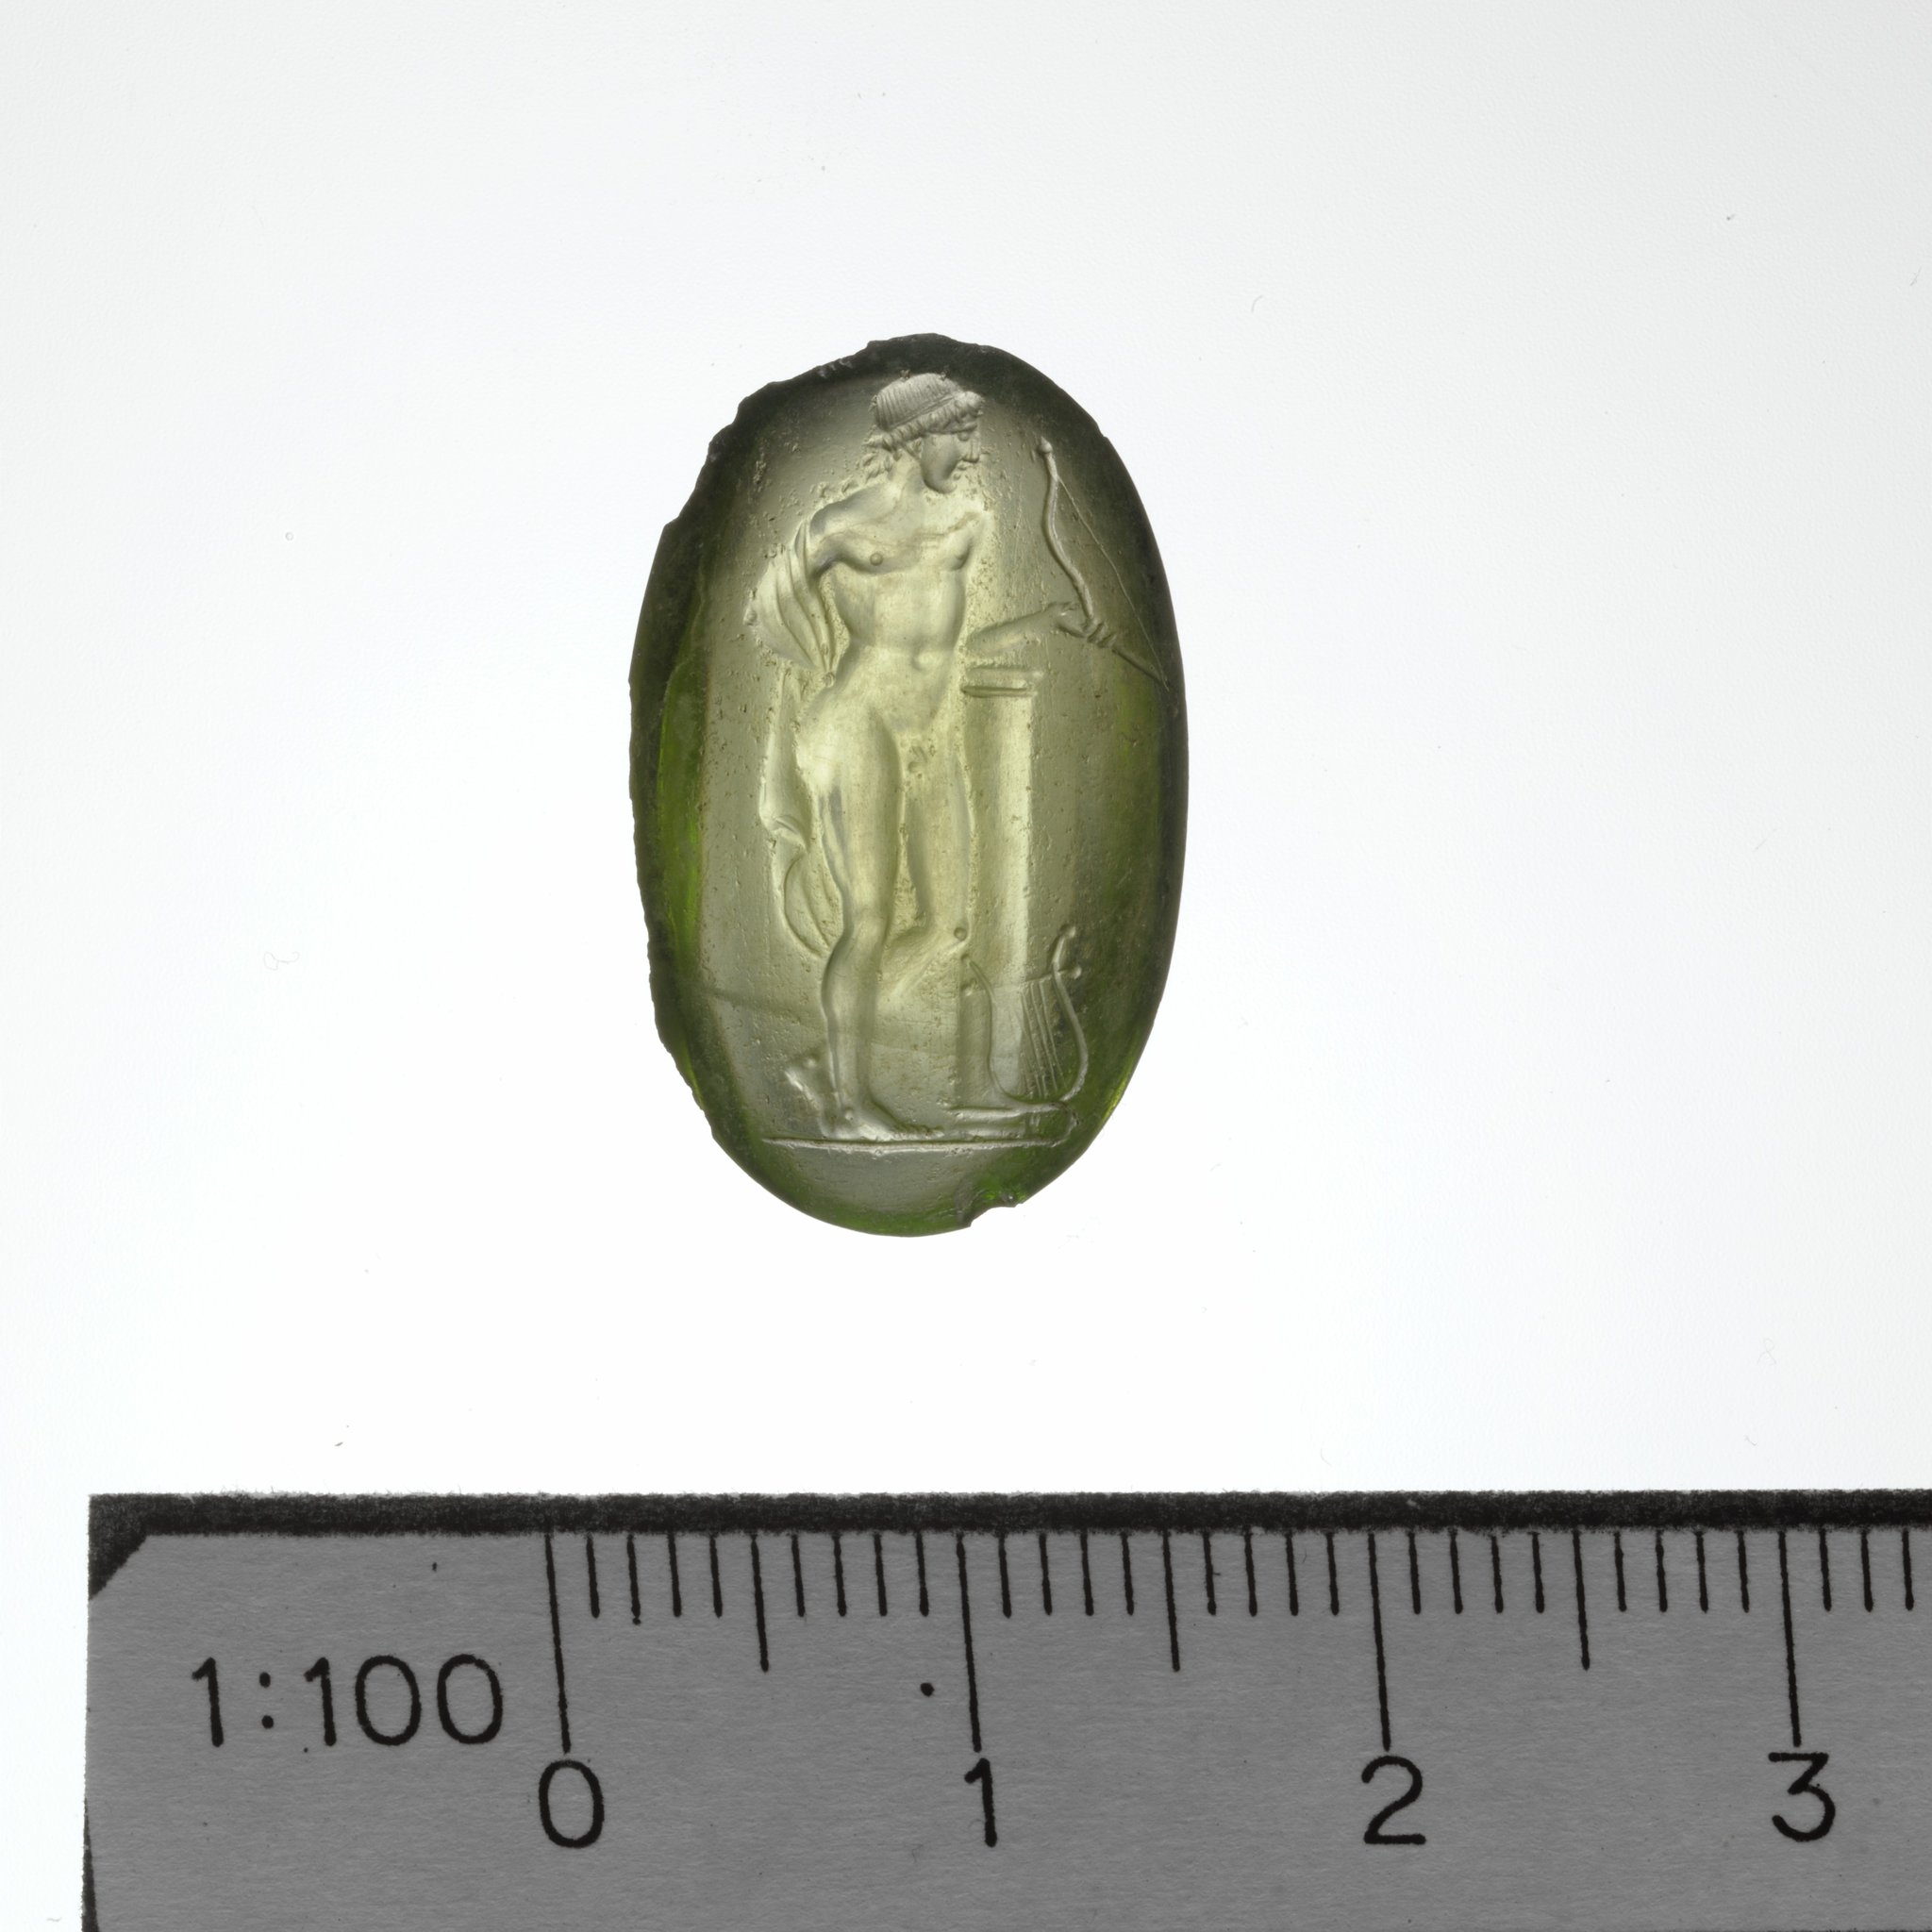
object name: intaglio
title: Peridot ring stone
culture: roman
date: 100 BCE-200 CE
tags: bow and arrow,apollo